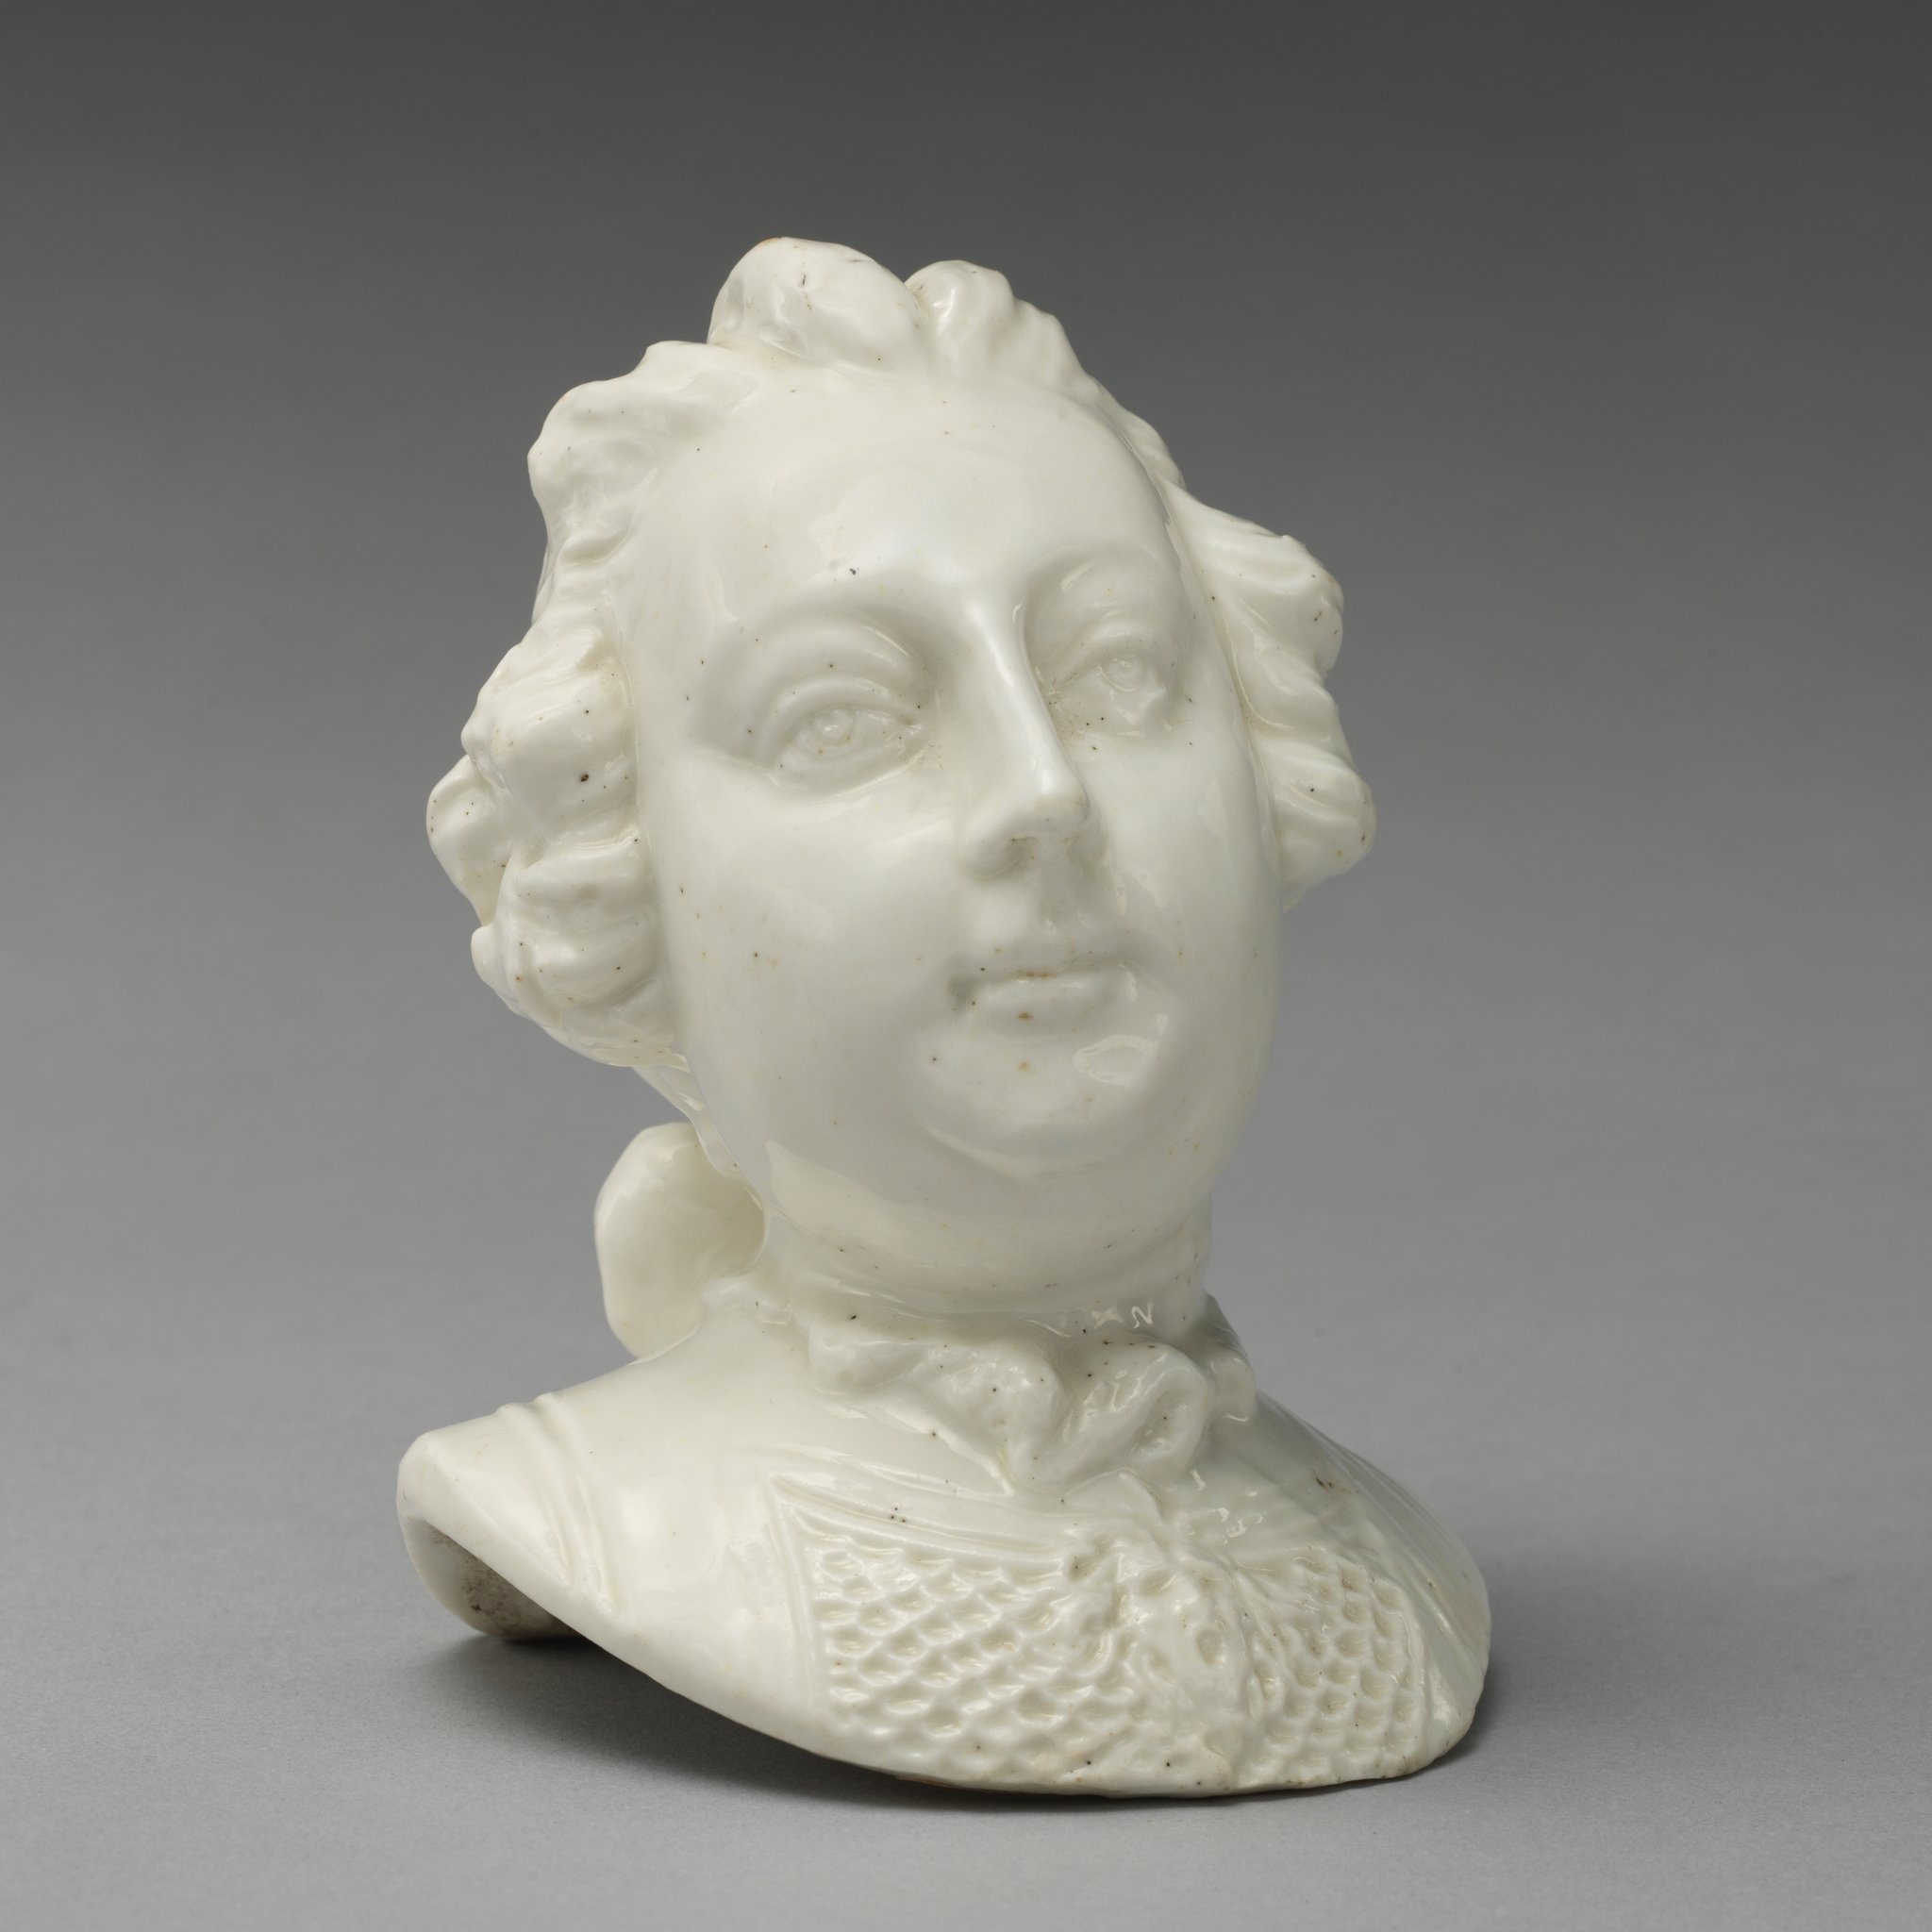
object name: bust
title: William Augustus, Duke of Cumberland (1721–1765)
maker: chelsea porcelain manufactory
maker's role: factory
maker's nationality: british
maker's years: 1744-1784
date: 1749-1752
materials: soft paste porcelain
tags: men